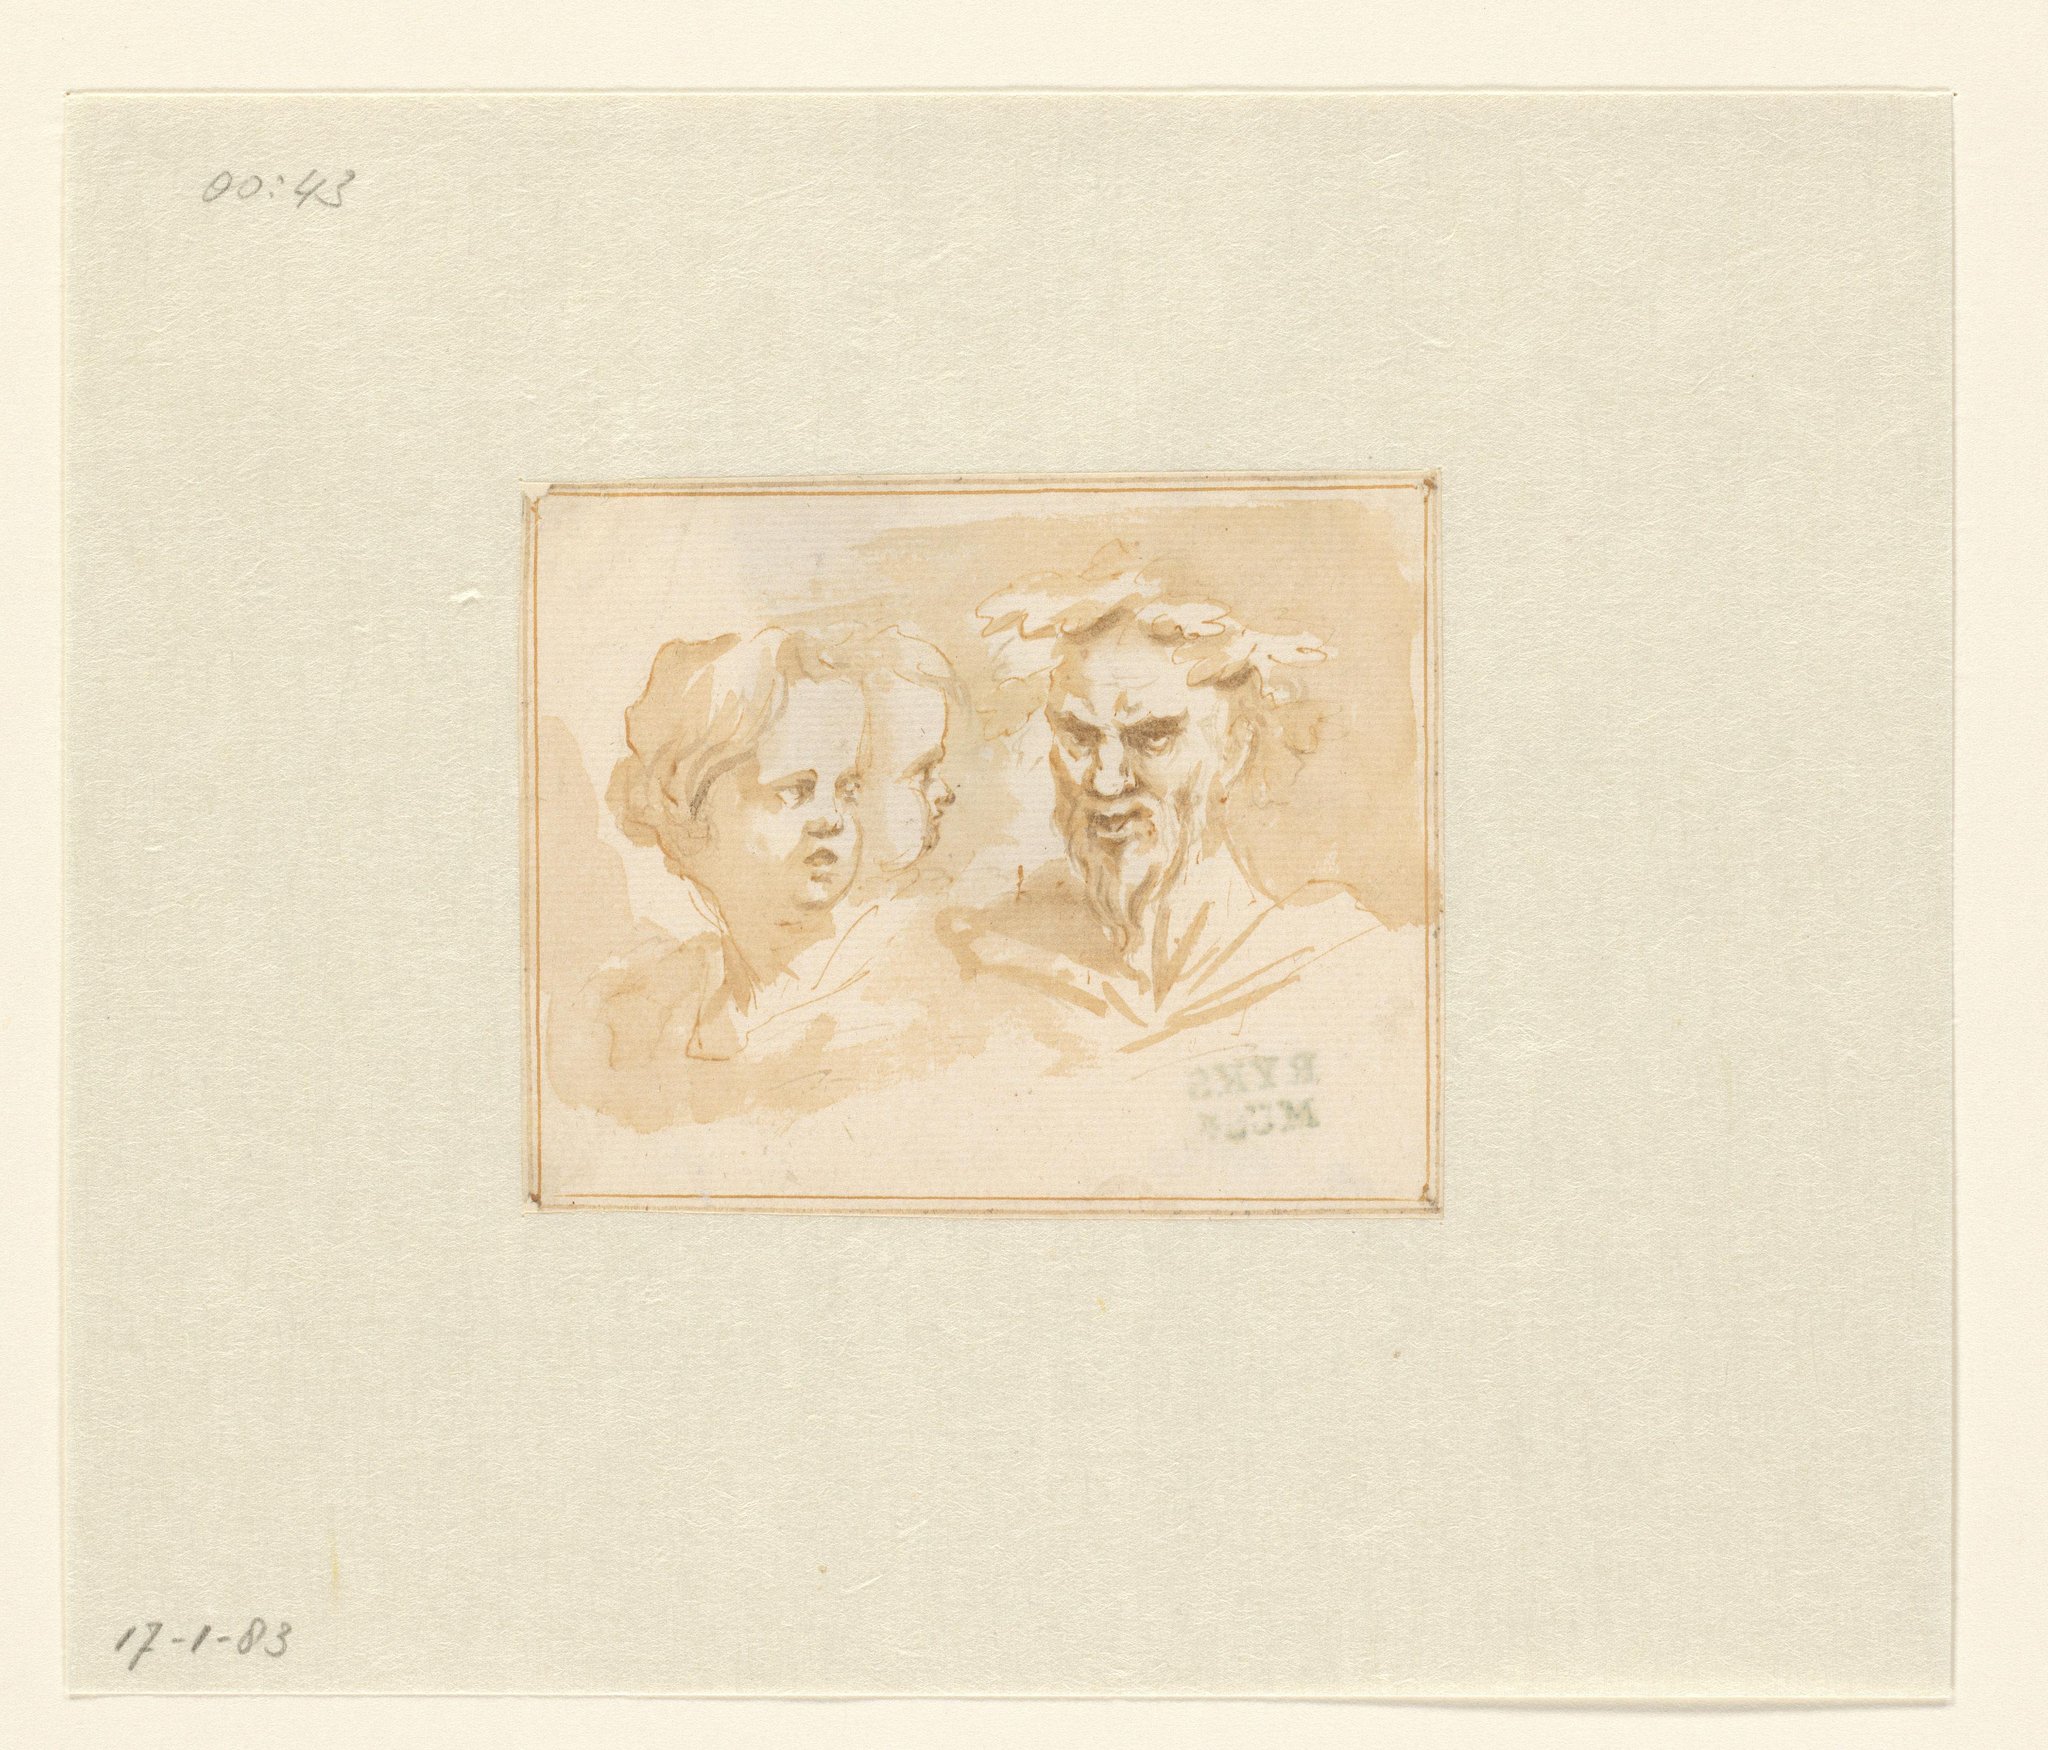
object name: drawing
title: Twee kinderen en een sater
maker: jan de bisschop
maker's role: draughtsman, print maker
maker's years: 1628-1671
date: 1648-1671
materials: ink, paper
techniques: brush, pen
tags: satyrs, fauns, sileni, child